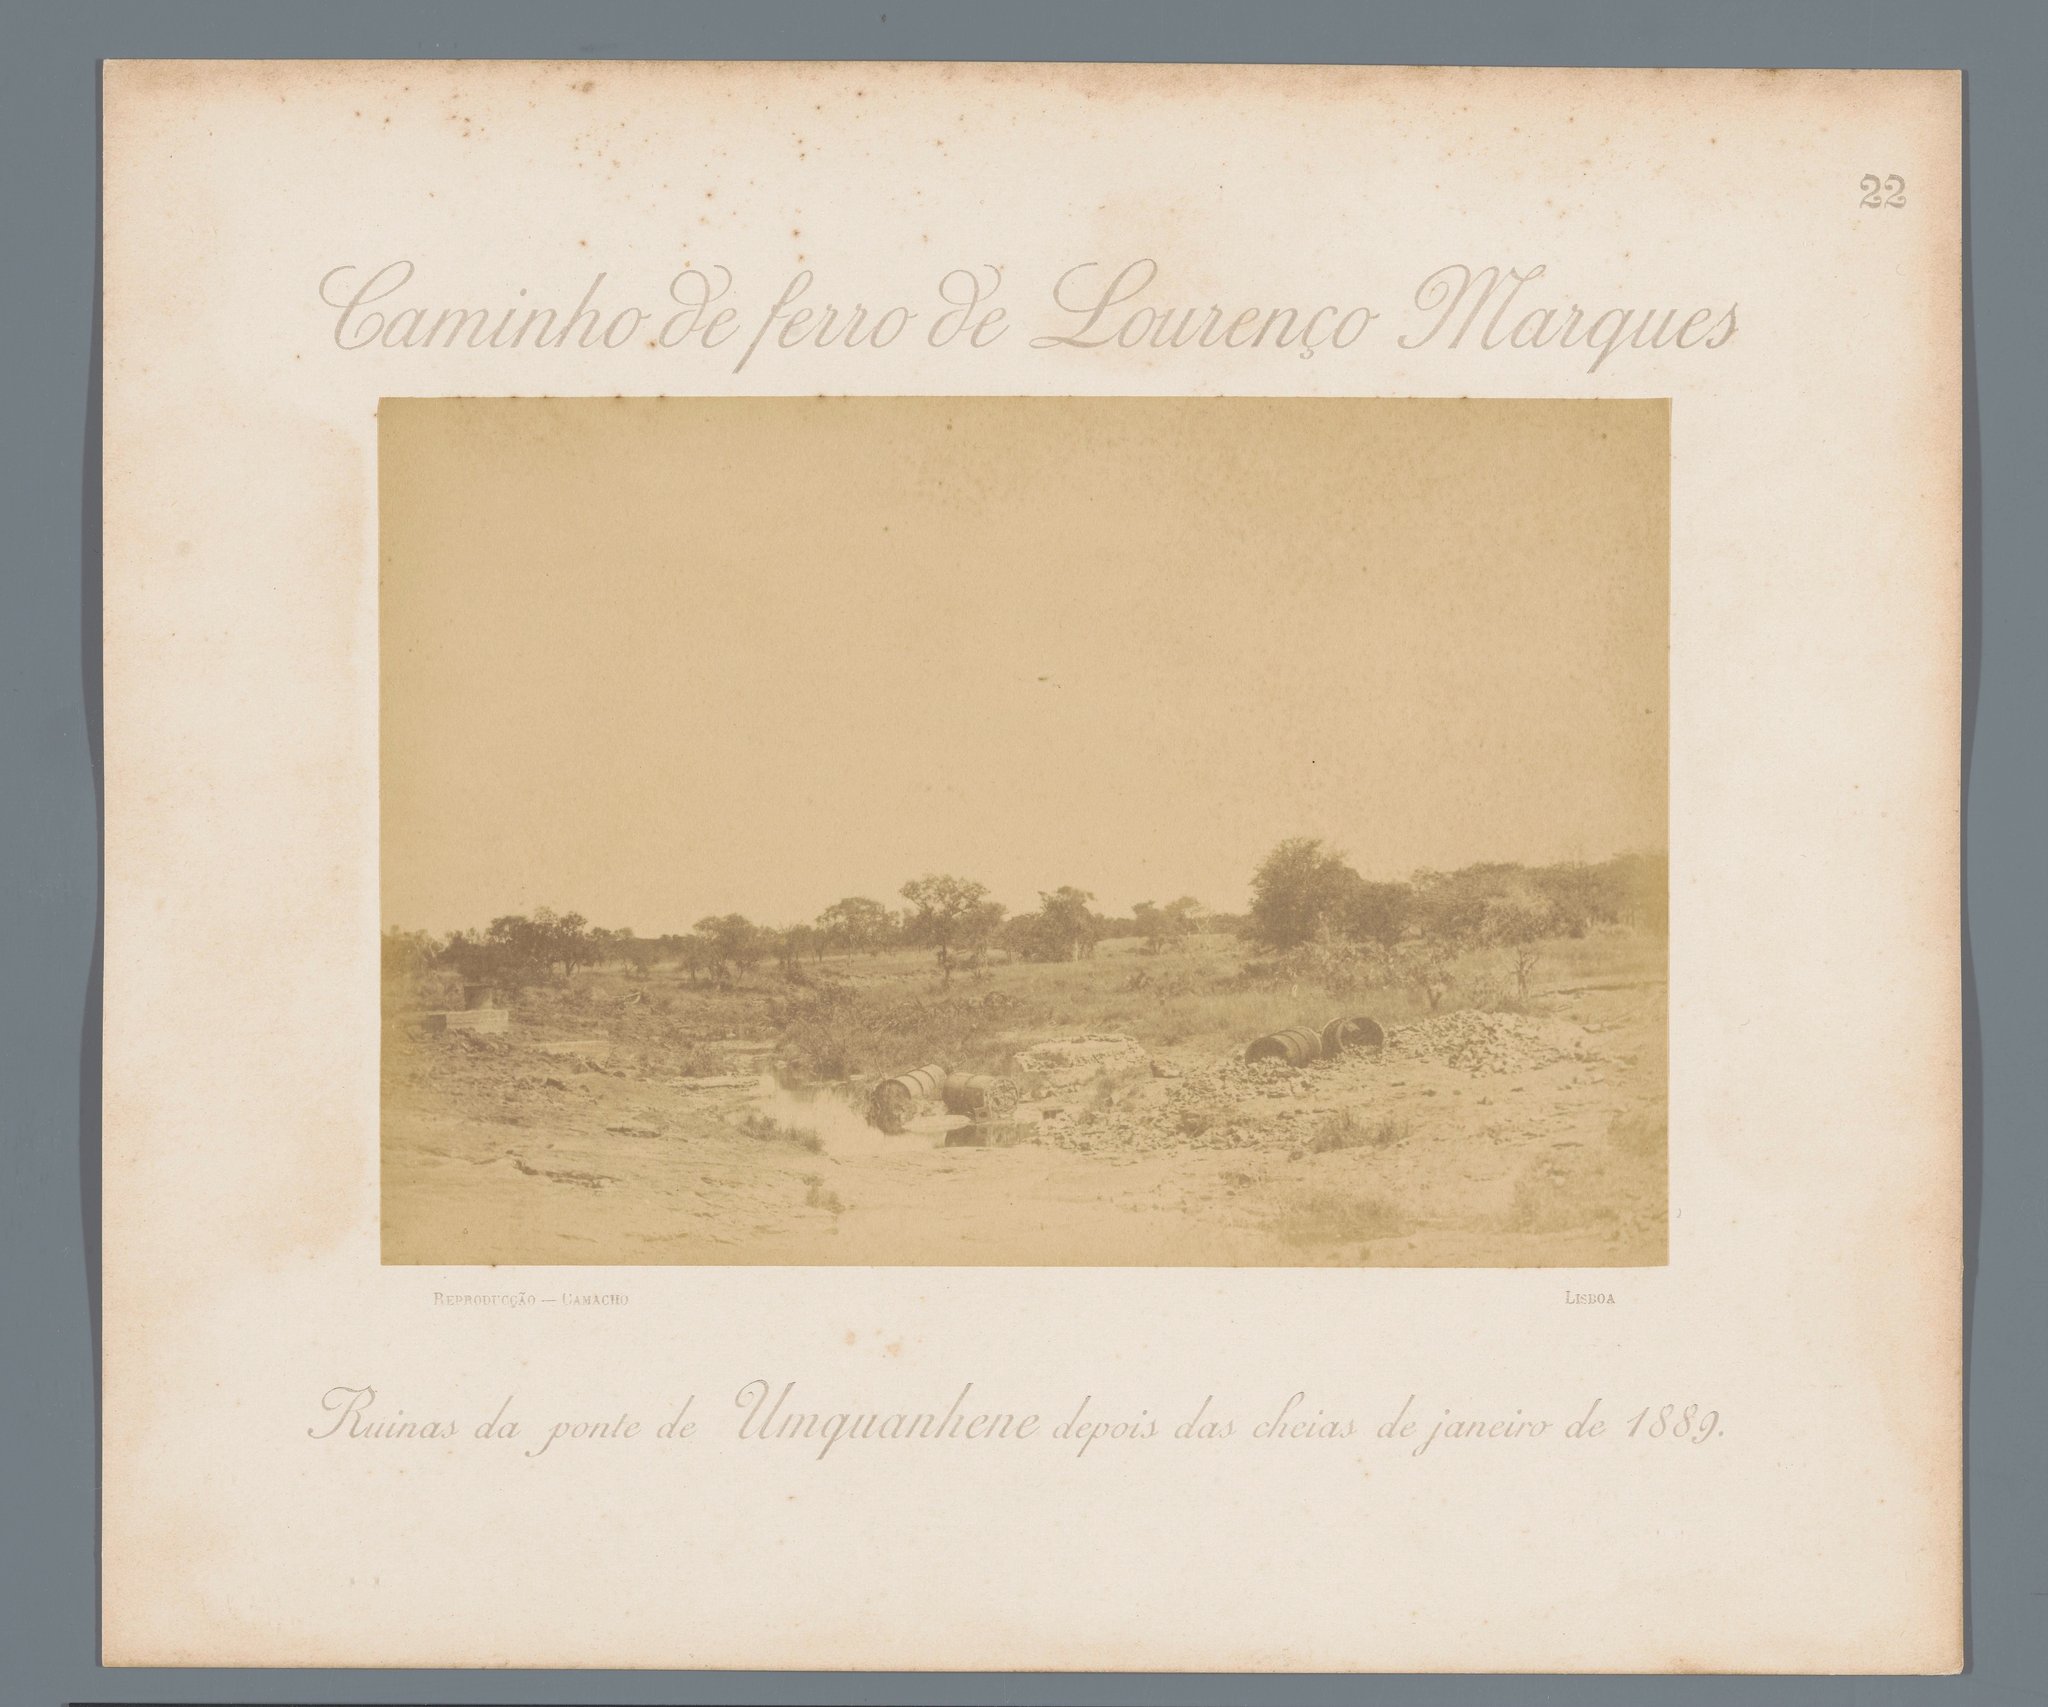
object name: page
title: Resten van een verwoeste spoorbrug bij Umquanhene in Mozambique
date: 1886-1895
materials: photographic support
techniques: albumen print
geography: lisbon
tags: bridges by construction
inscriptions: number: ‘22’